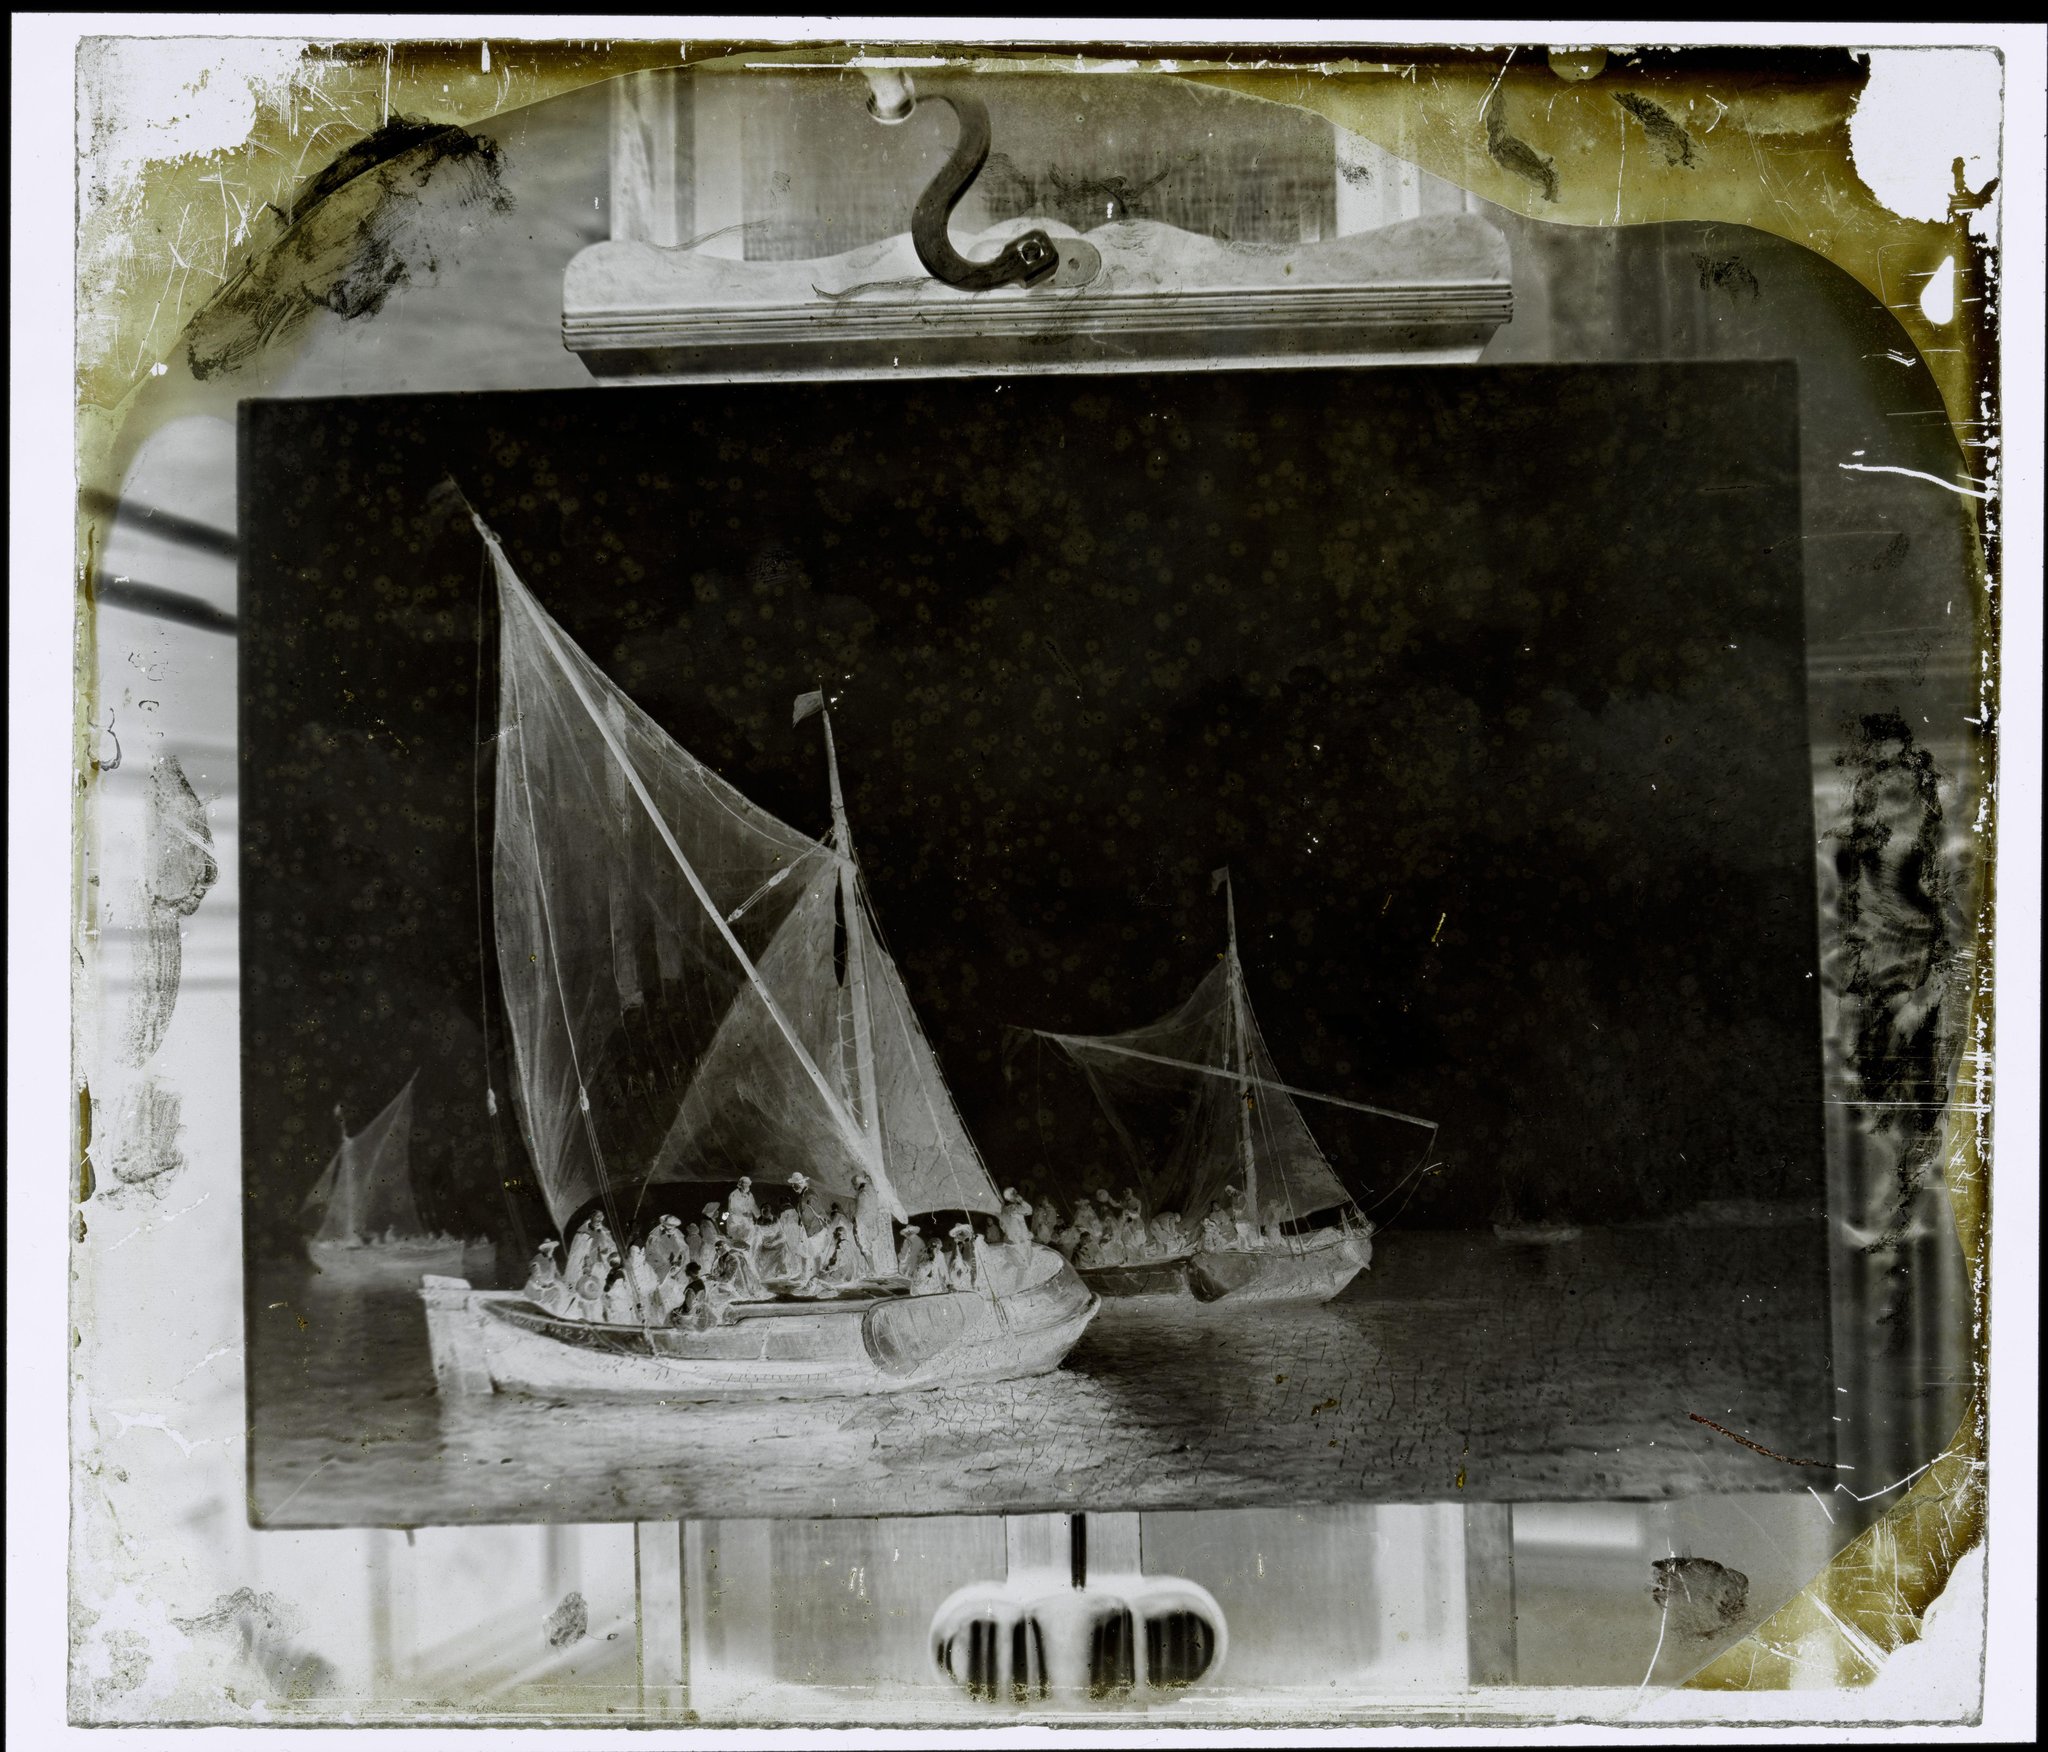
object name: reproduction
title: Fotoreproductie van een schilderij van zeilschepen op zee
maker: laurens lodewijk kleijn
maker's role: draughtsman, painter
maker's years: 1826-1909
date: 1865-1900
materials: glass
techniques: collodion process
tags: ships (in general) - cc - more than one ship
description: Onderdeel van een groep glasnegatieven uit de nalatenschap van de schilder Laurens Lodewijk Kleijn, met stillevens, portretten, zelfportretten en kunstreproducties.